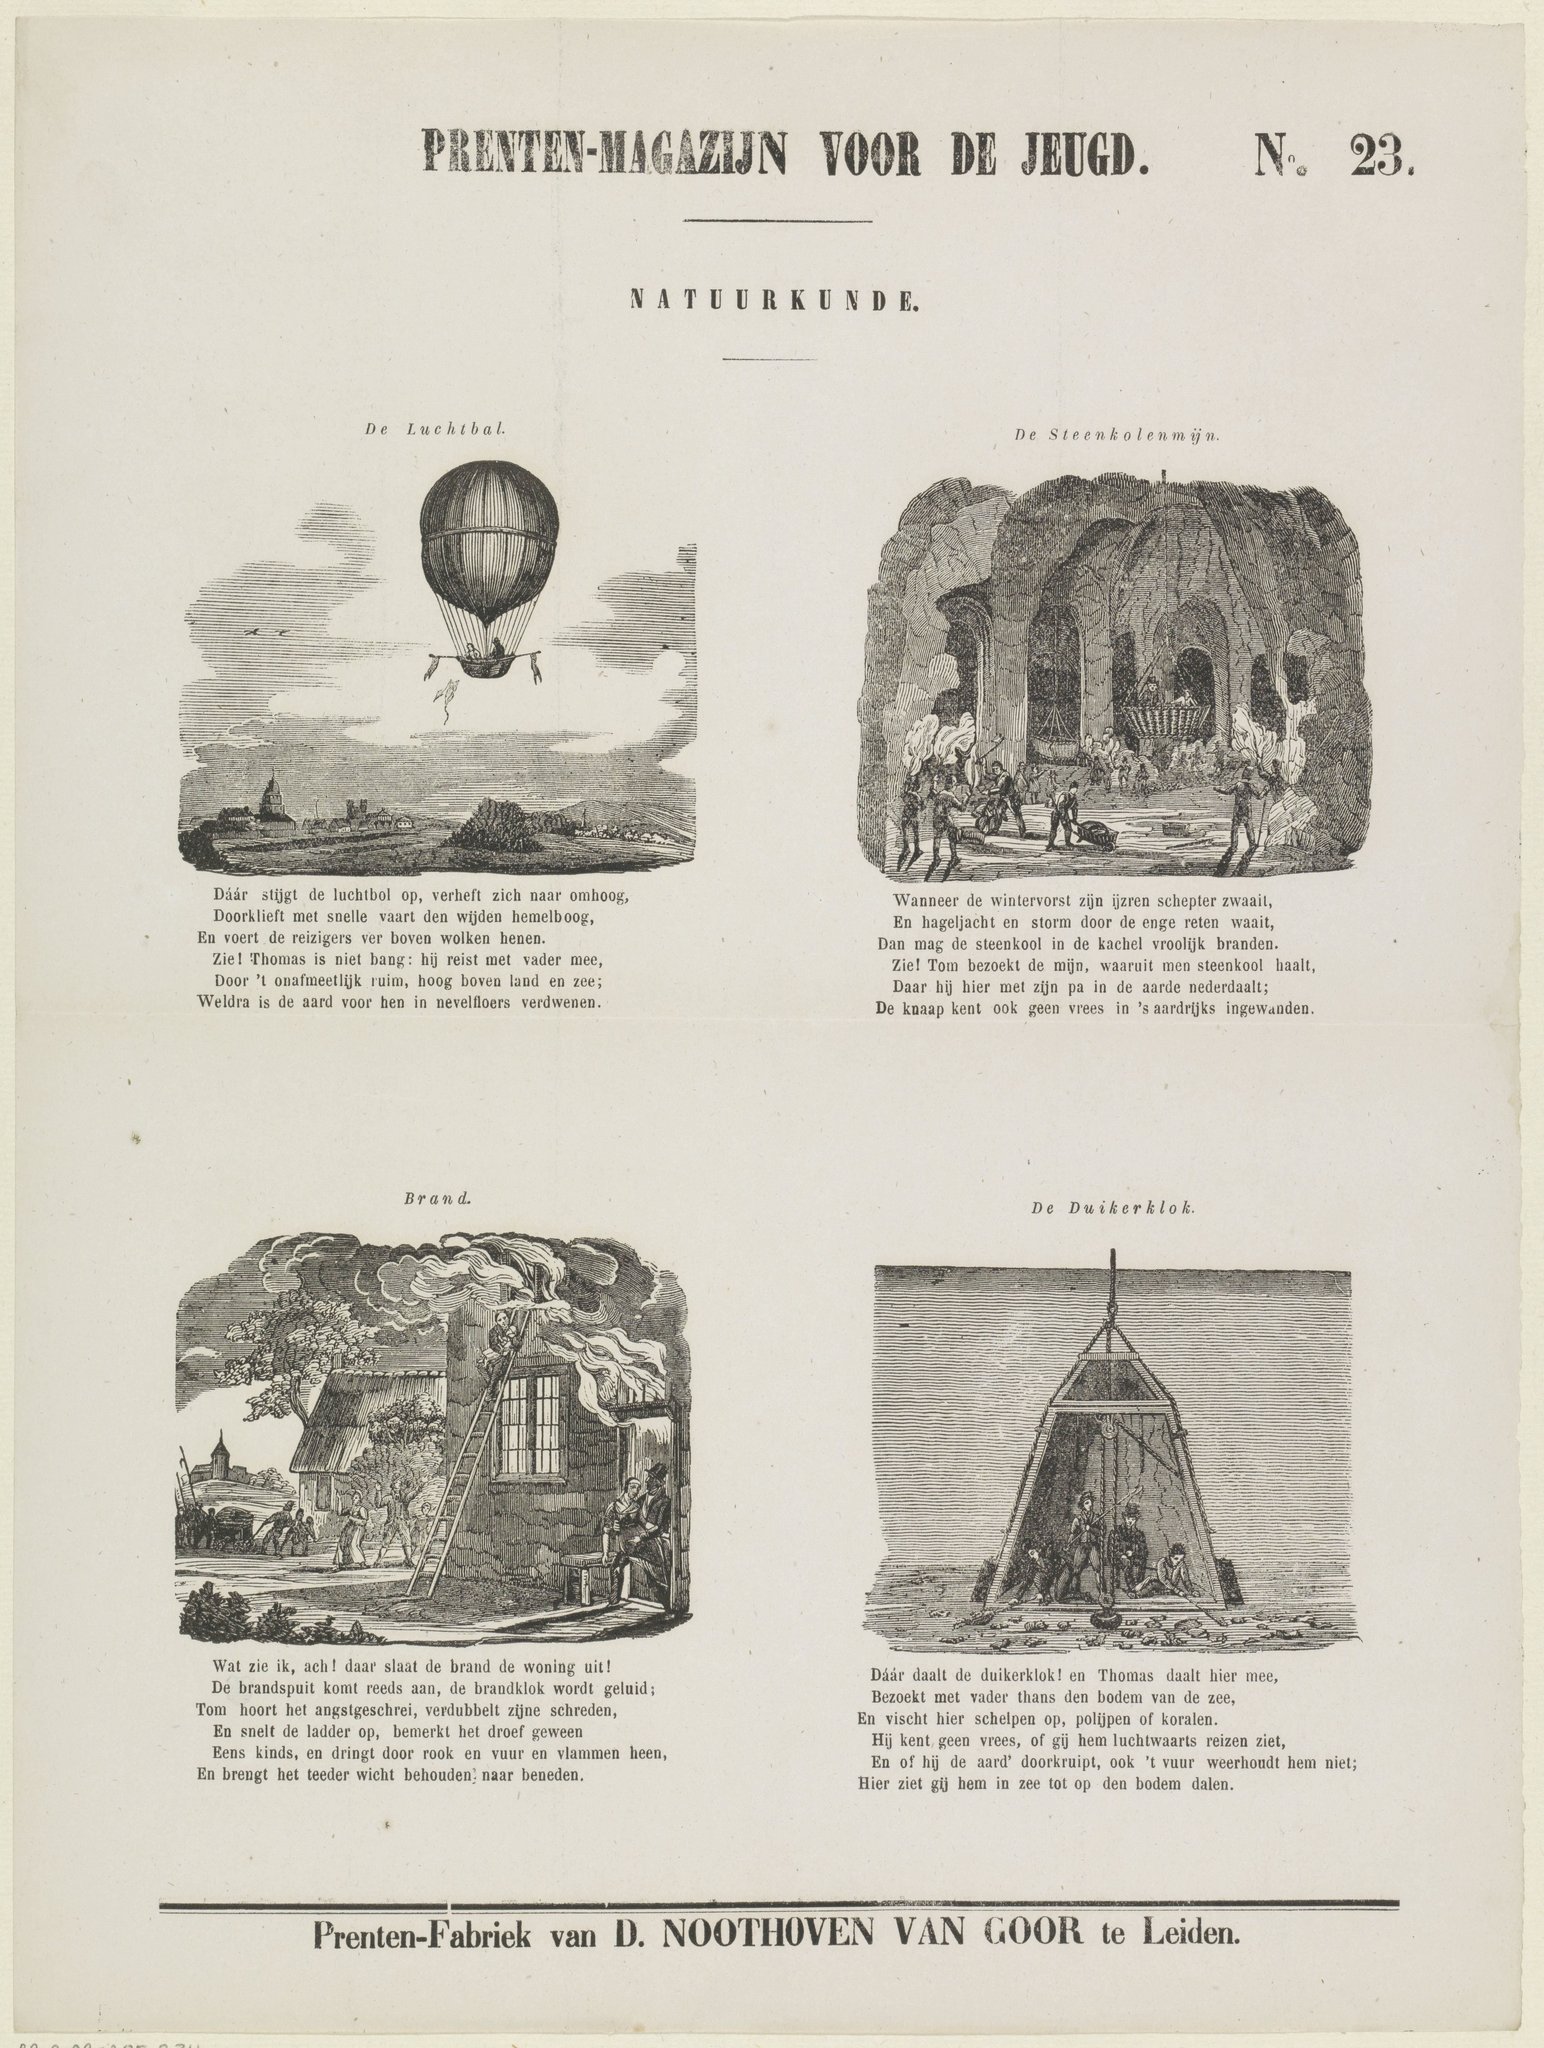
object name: print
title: Natuurkunde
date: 1850-1881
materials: paper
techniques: letterpress printing, engraving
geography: leiden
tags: on fire, ablaze, (flying a) gas balloon, balloon flight (sport), diving-bell, bathysphere, mine (+ coal), mine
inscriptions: collector's mark: Lugt 2760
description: Blad met 4 voorstellingen van natuurkundige zaken: een luchtballon, een steenkolenmijn, brand en een duikerklok. Boven elke voorstelling een titel en onder elke voorstelling een zesregelig vers. Genummerd rechtsboven: No. 23.